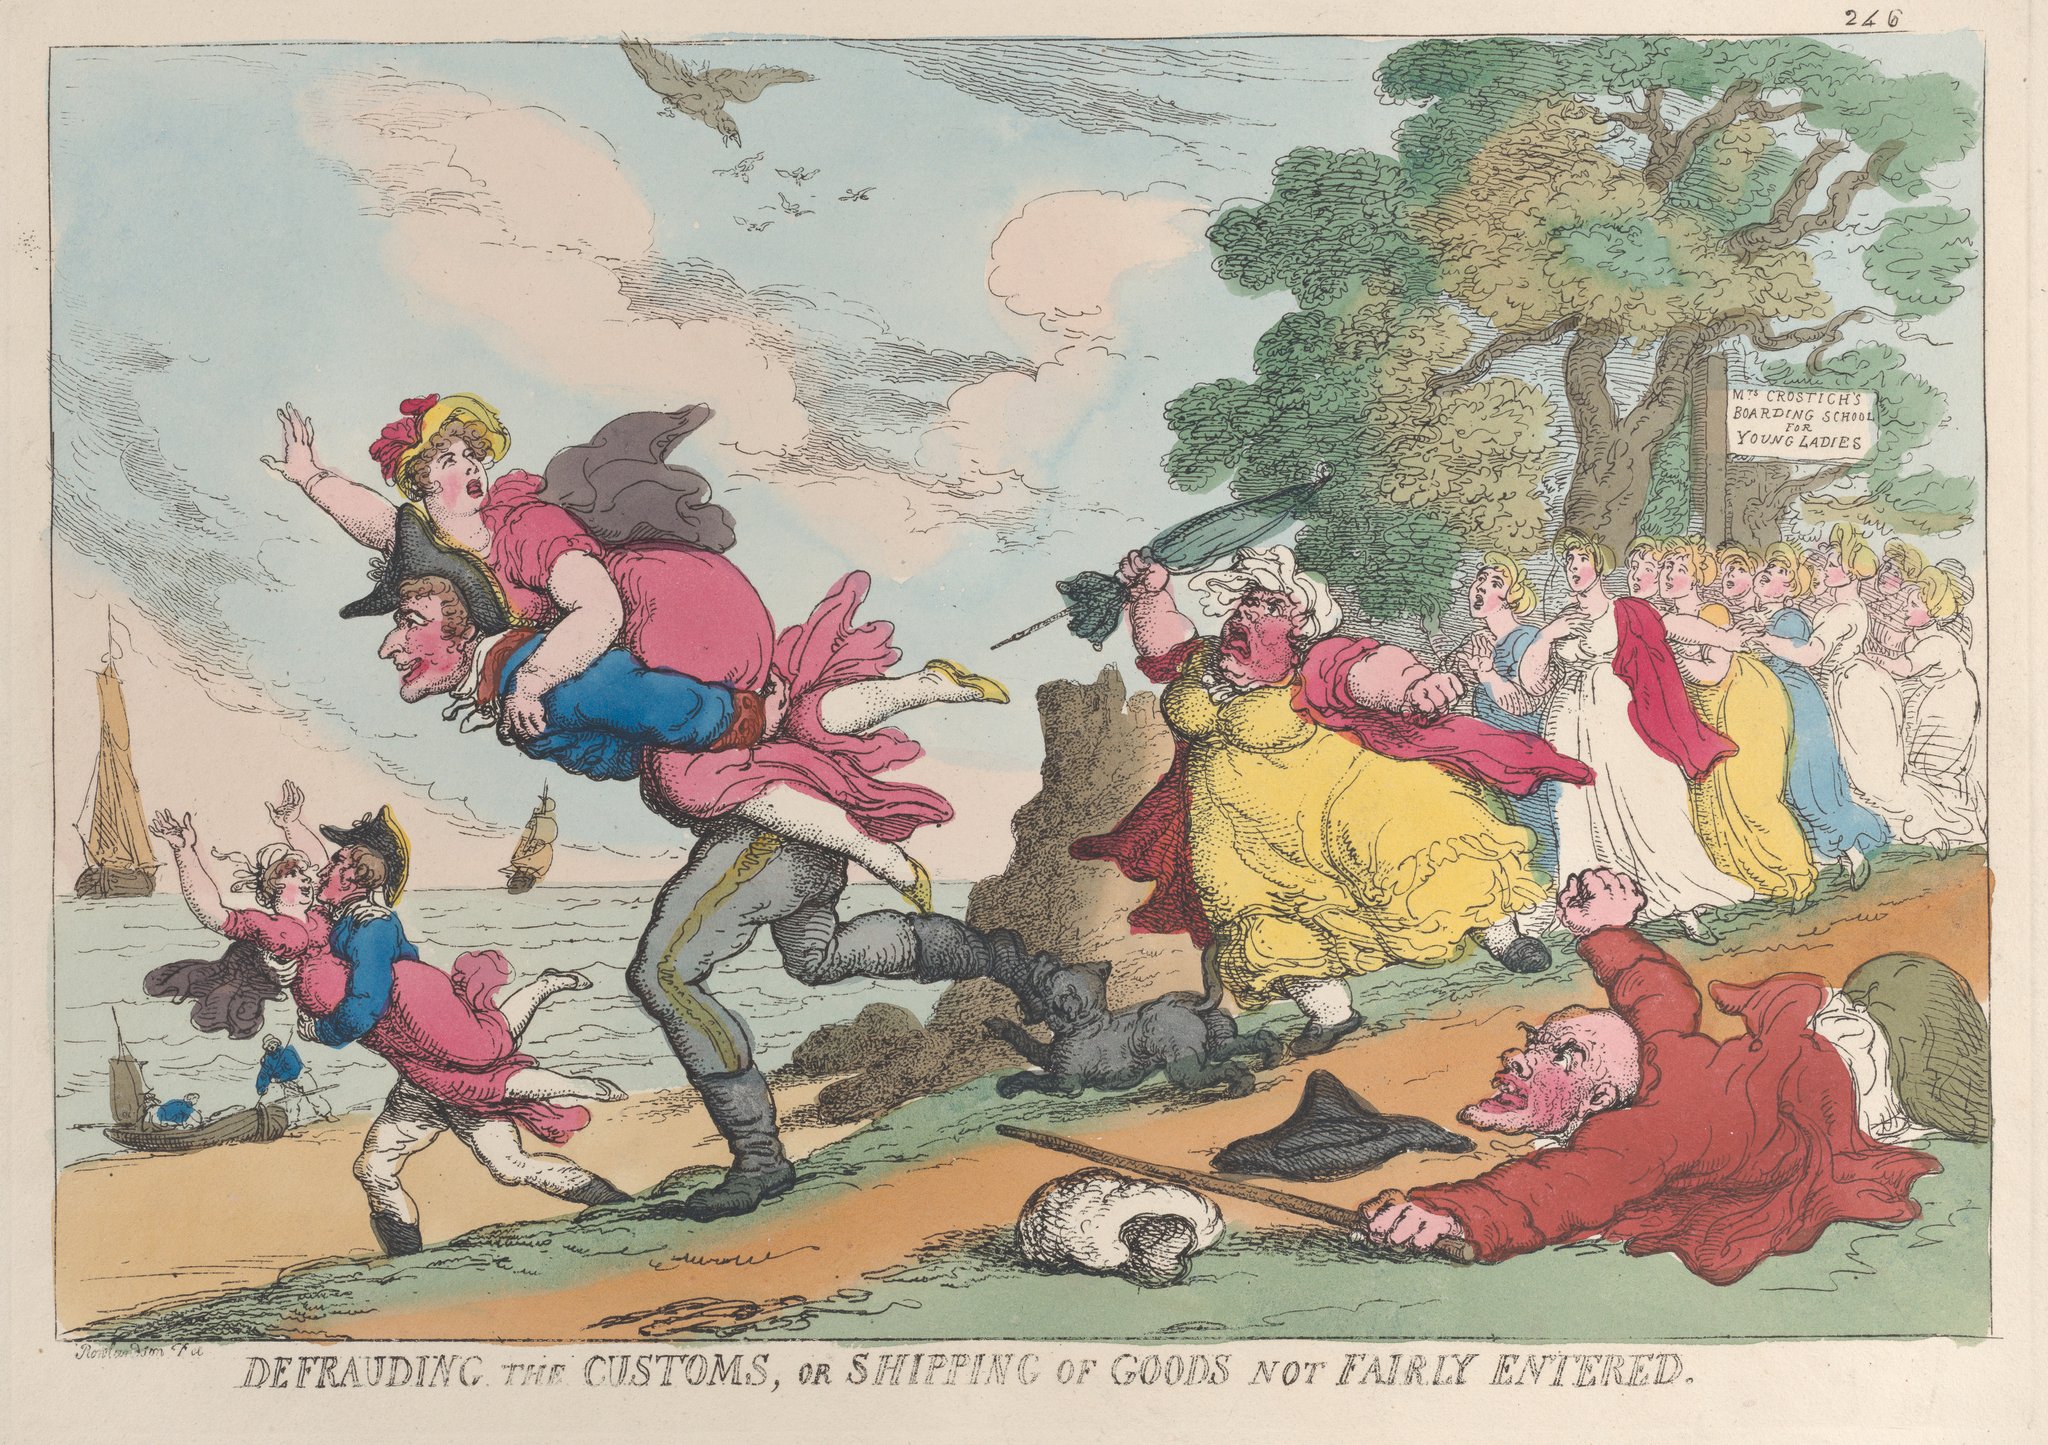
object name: print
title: Defrauding the Customs, or Shipping the Goods Not Fairly Entered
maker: thomas rowlandson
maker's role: artist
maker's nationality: british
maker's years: 1757-1827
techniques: etching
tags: satire,men,women